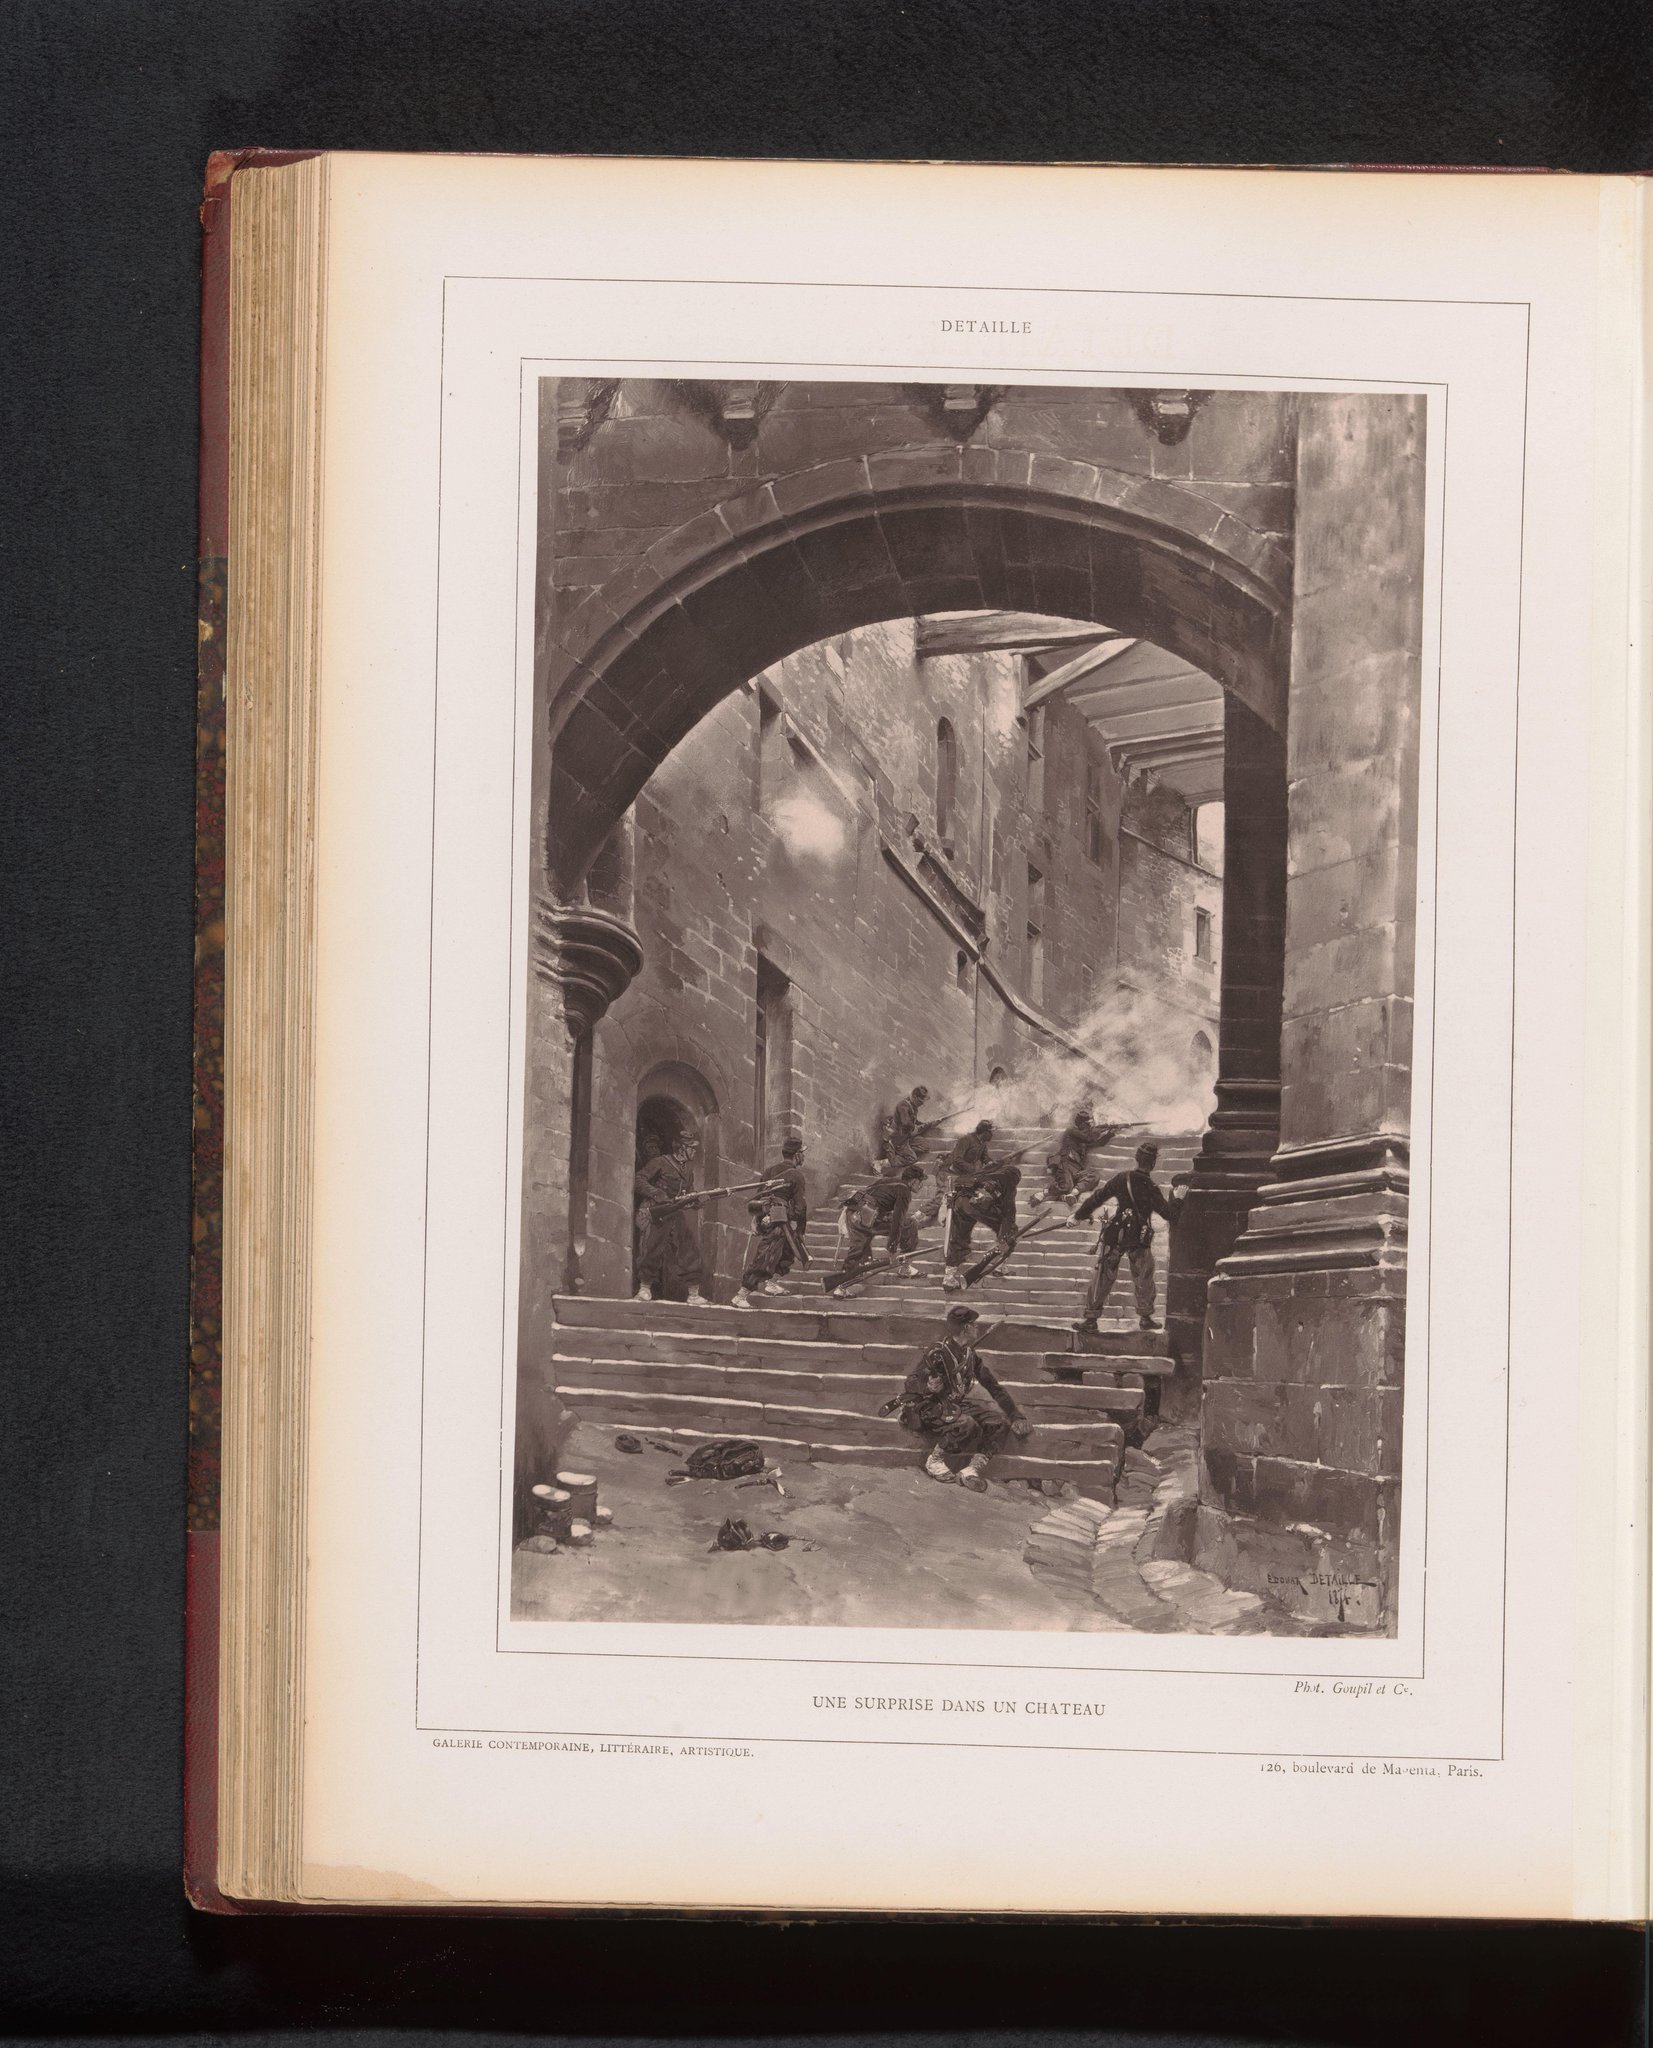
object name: page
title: Une surprise dans un chateau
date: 1872-1877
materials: paper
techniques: woodburytype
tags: the soldier; the soldier's life (+ during the battle), painting, drawing and the graphic arts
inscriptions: inscription: ‘Detaille/ Galerie Contemporaine, Littéraire, Artistique/ 126, boulevard de Magenta, Paris’